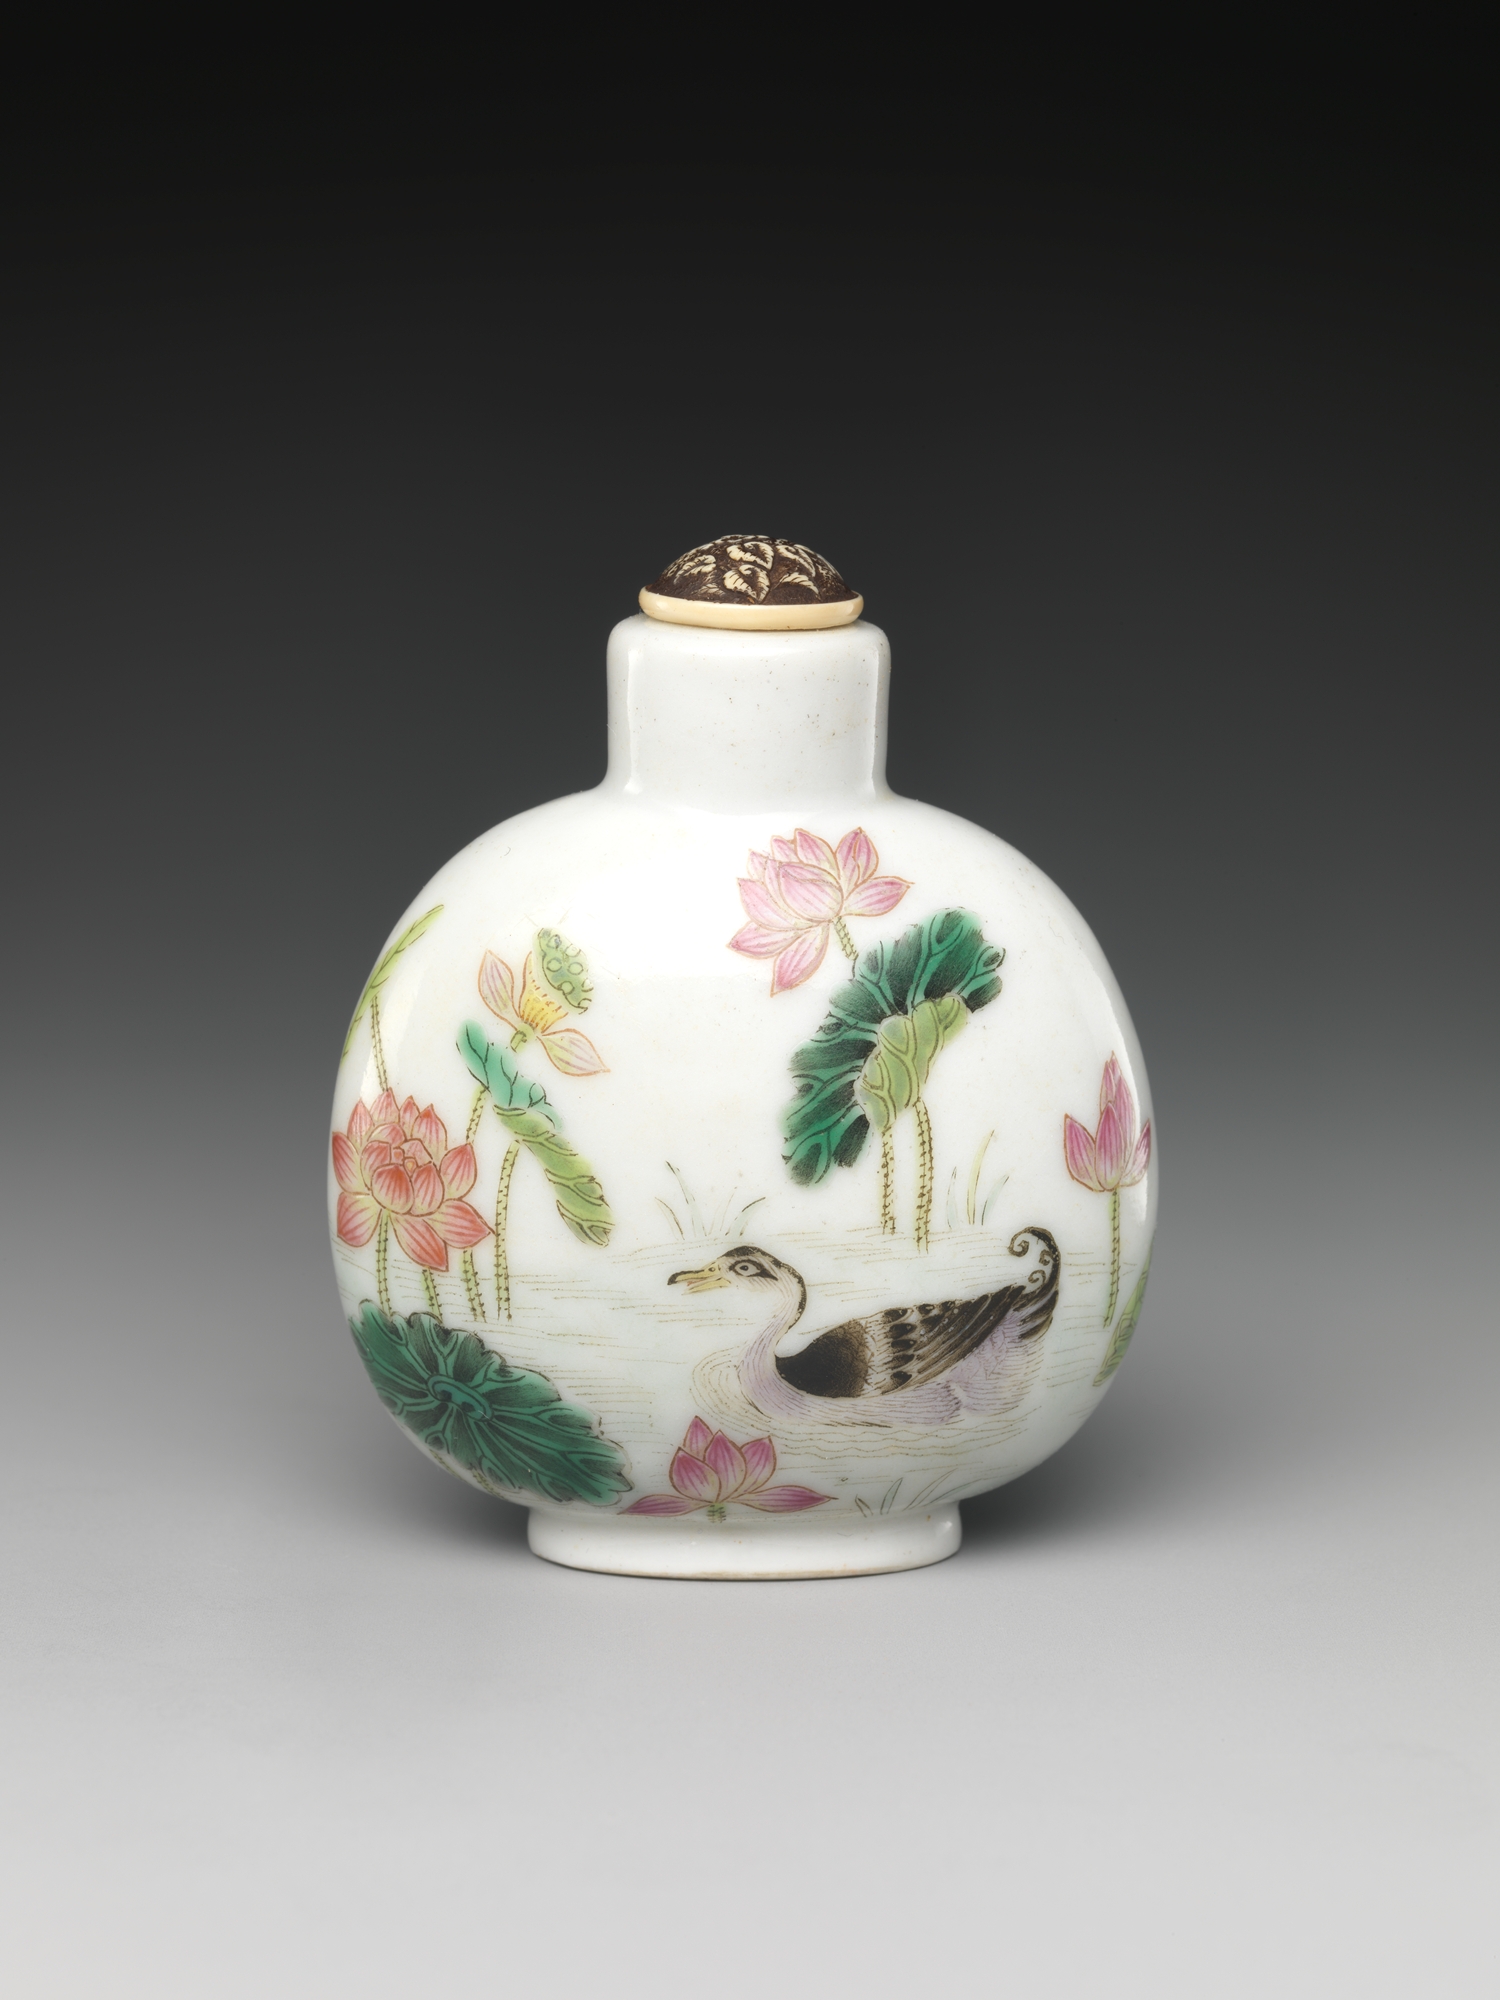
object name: snuff bottle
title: Snuff Bottle with Scene of a Lotus Pond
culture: chinese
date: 1821-1850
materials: enamel, ivory, porcelain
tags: ducks,lotuses